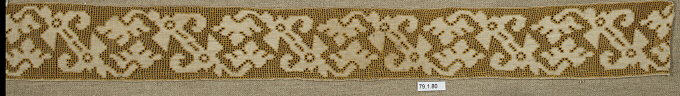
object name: border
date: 1501-1600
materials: linen, silk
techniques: embroidery